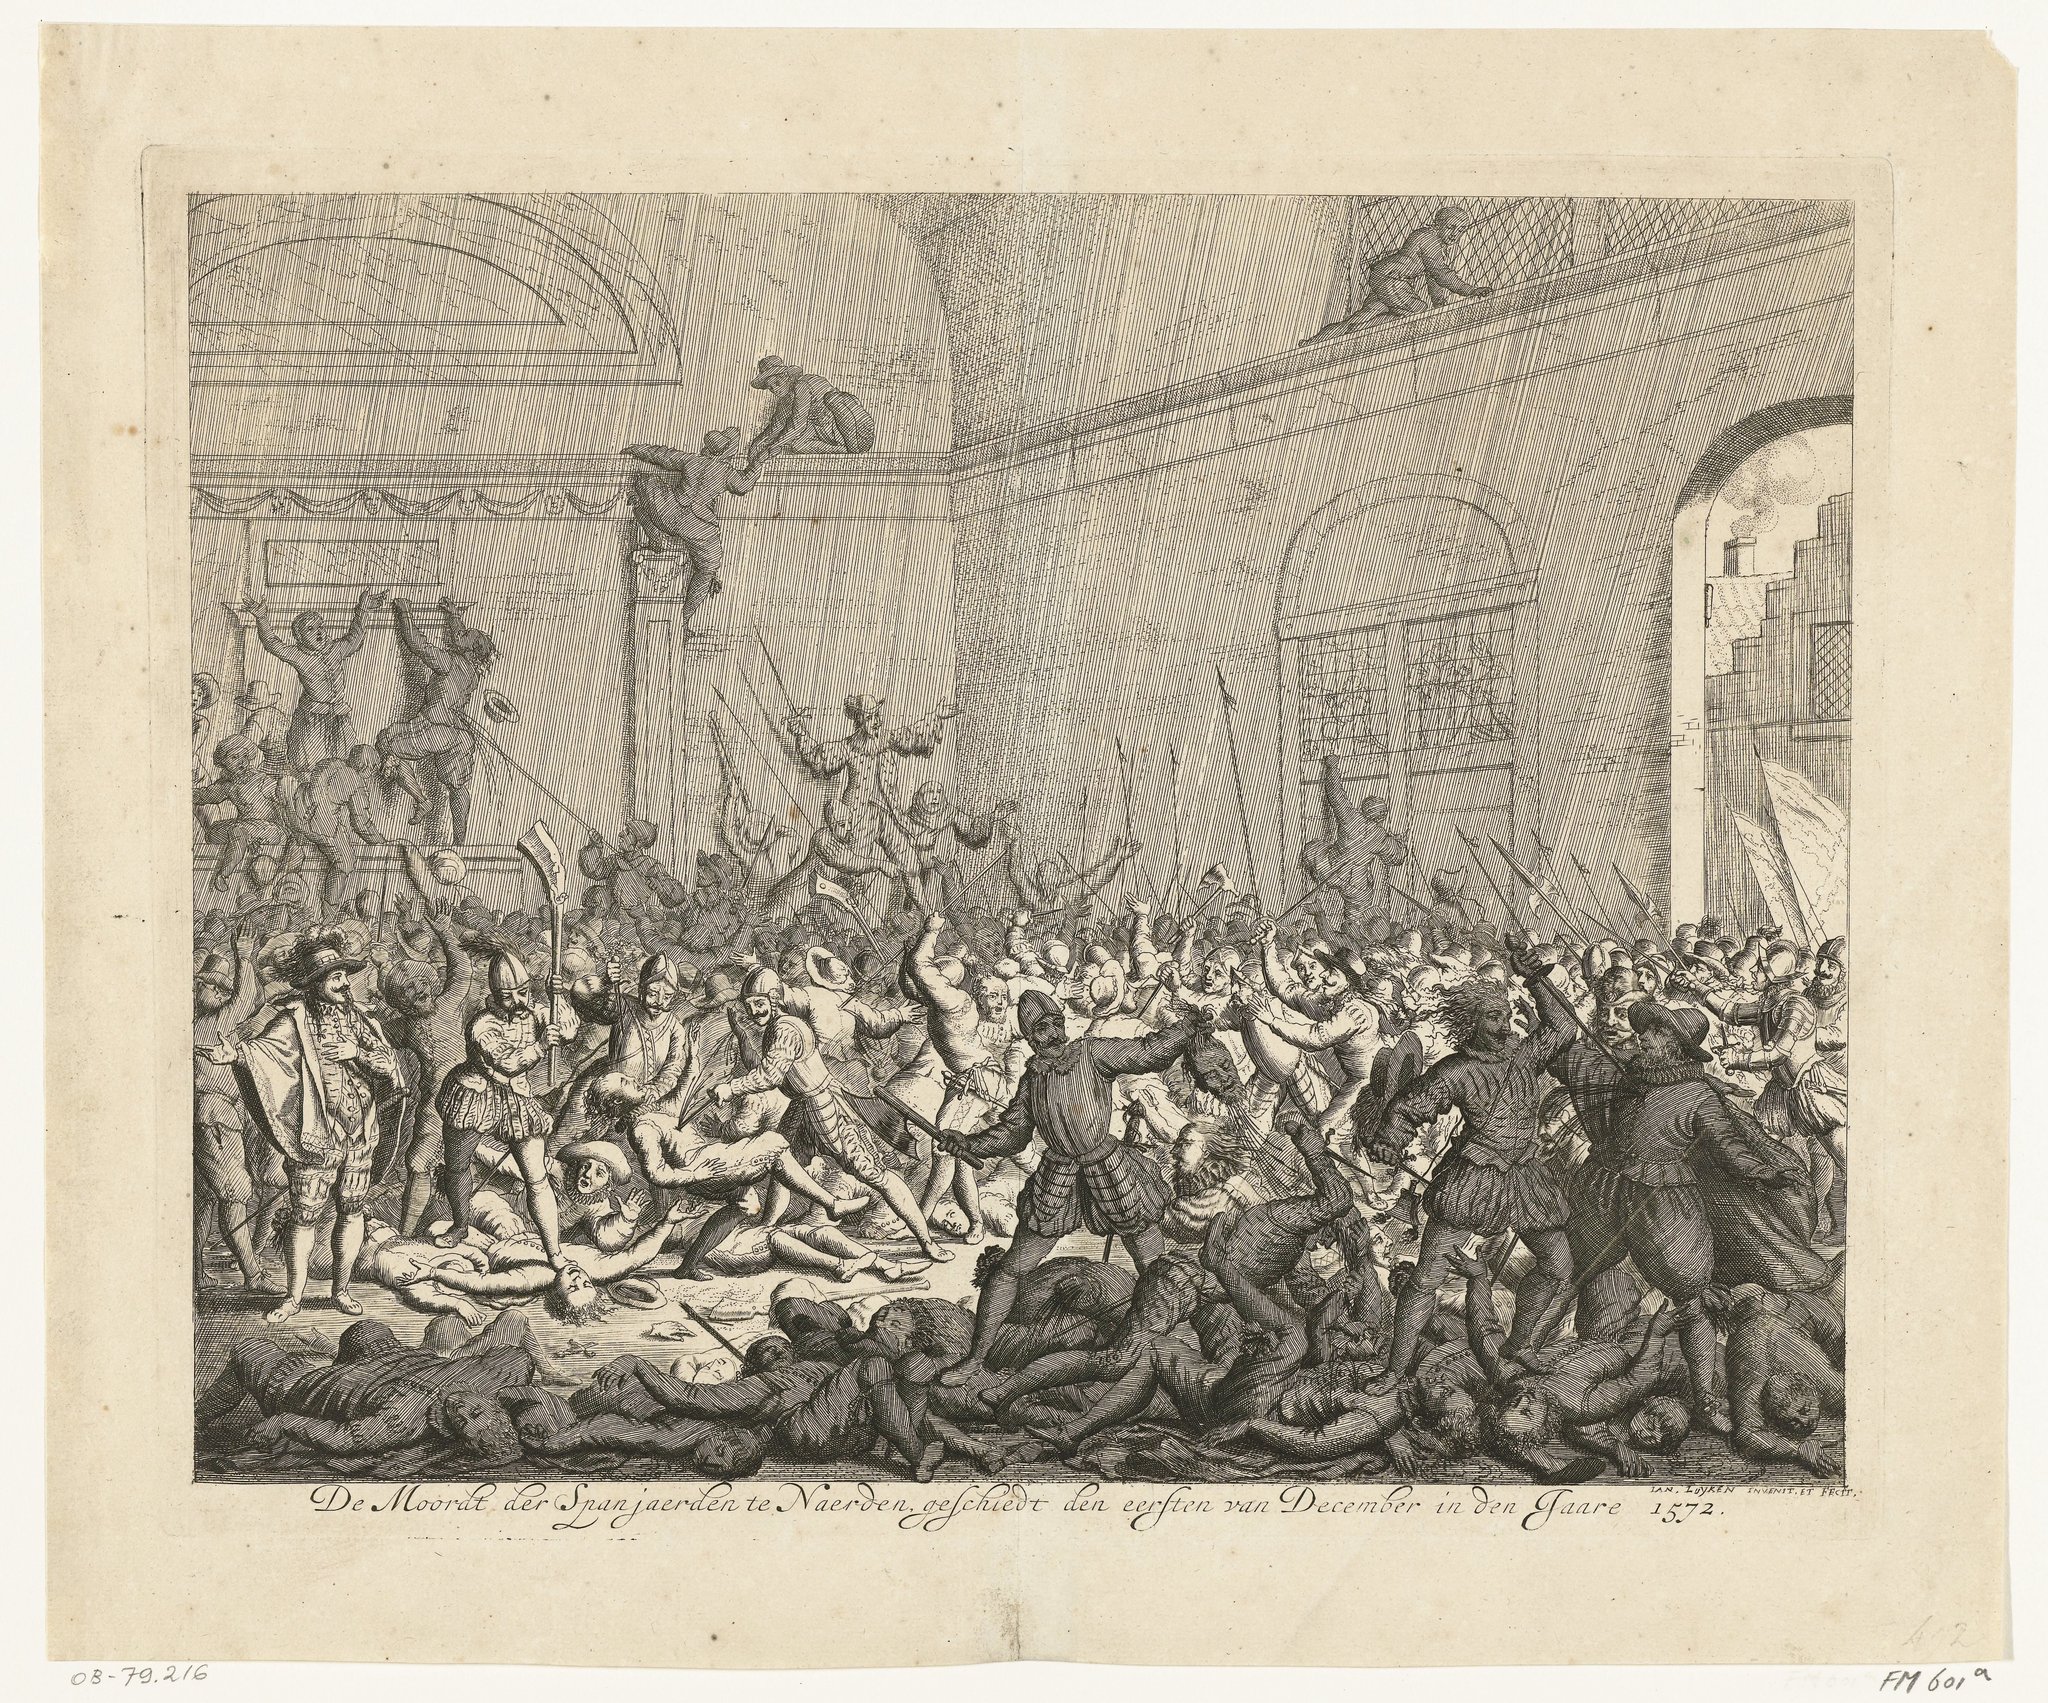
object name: print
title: De moord der Spanjaerden te Naerden, geschiedt den eersten van december in den jaare 1572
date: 1679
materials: paper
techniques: engraving, etching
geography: amsterdam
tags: massacre ~ war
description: Prent gebruikt in: Bor Christiaansz, Pieter. Oorsprongk, begin, en vervolgh der Nederlandsche oorlogen […], 4 delen. Amsterdam: weduwe Joannes van Someren, Abraham Wolfgang en Hendrick en Dirk Boom, 1679-1684, dl. 1 (1679), p. 418.